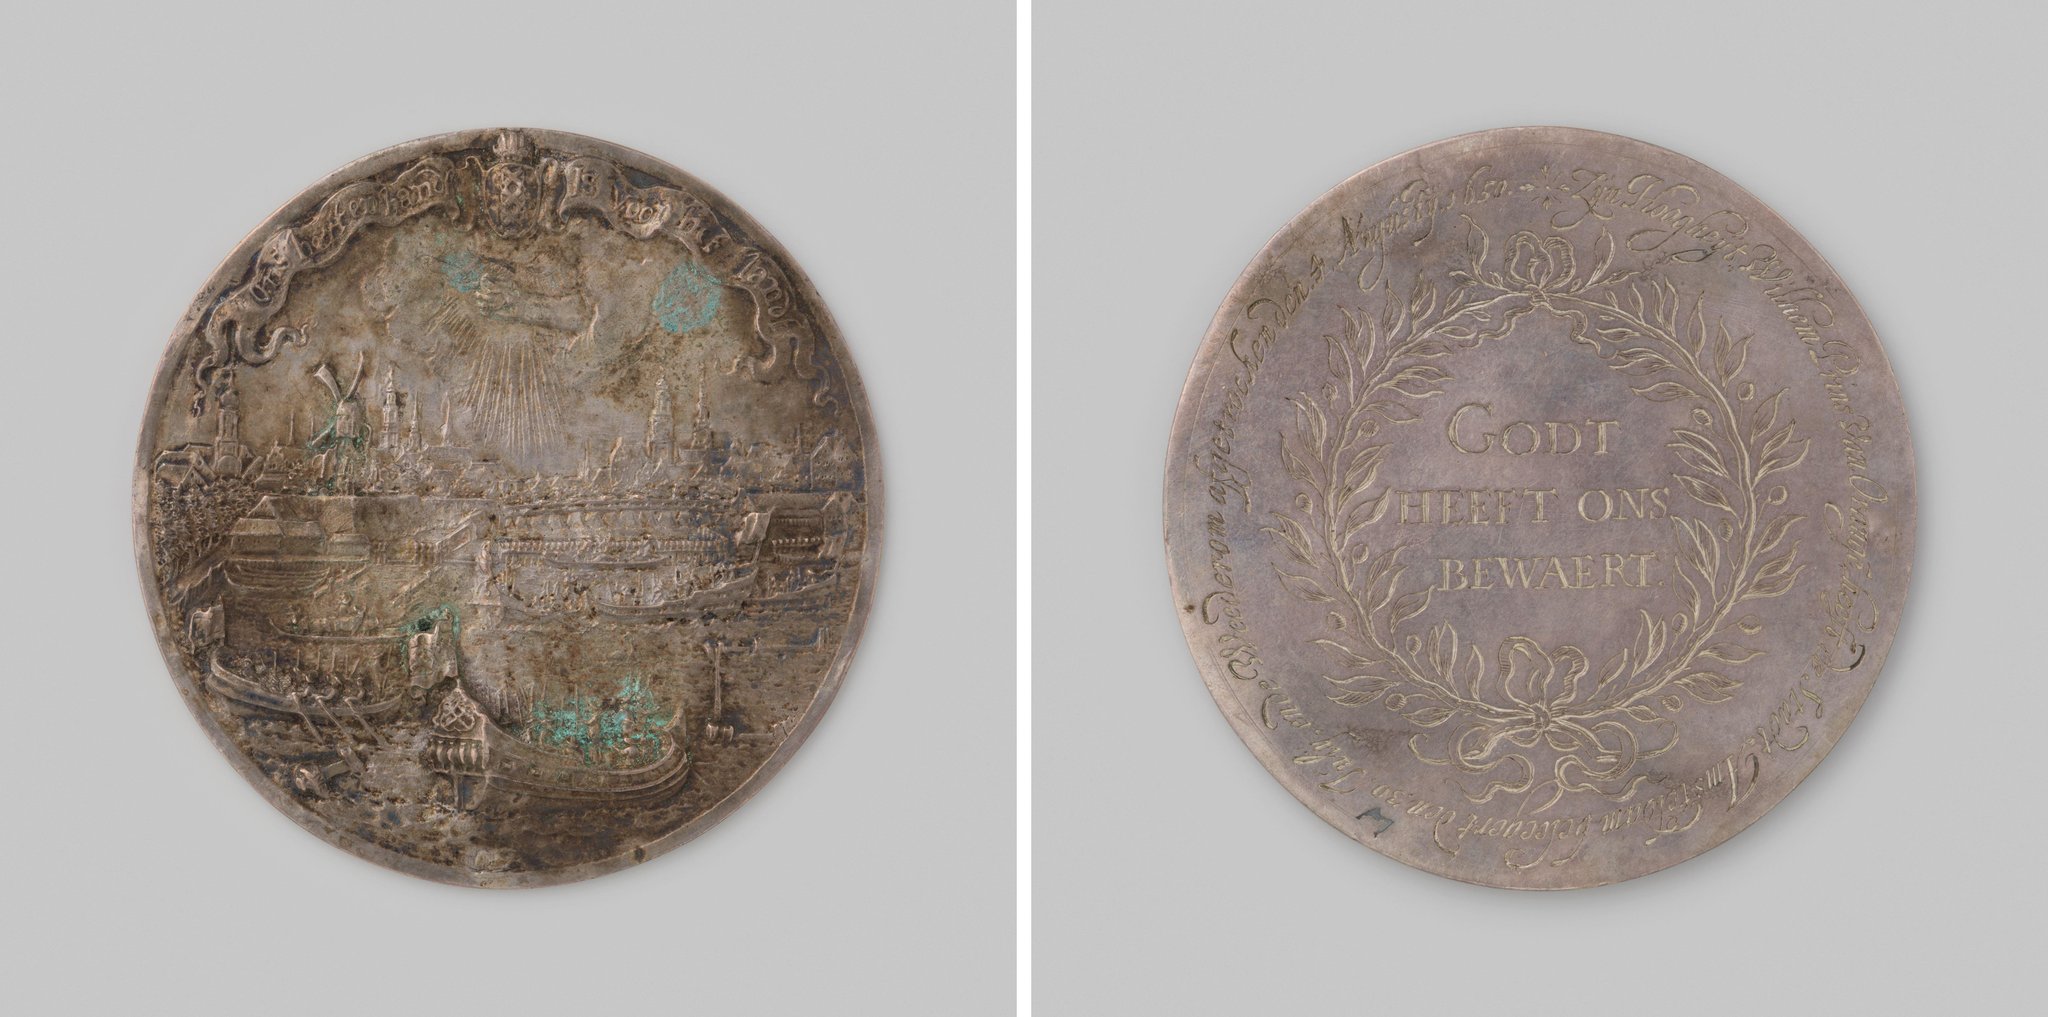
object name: history medal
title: Amsterdam belegerd door Willem II 1650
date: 1650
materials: silver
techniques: casting, engraving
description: Gegoten zilveren penning, op de voorzijde het aanzicht van Amsterdam met schepen vol krijgsvolk en uit de wolken een hand met een hart, bovenaan een lint met tekst en een Amsterdams wapenschild, de keerzijde gegraveerd GODT / HEEFT ONS / BEWAERT. tussen samengestrikte takken en een omschrift.